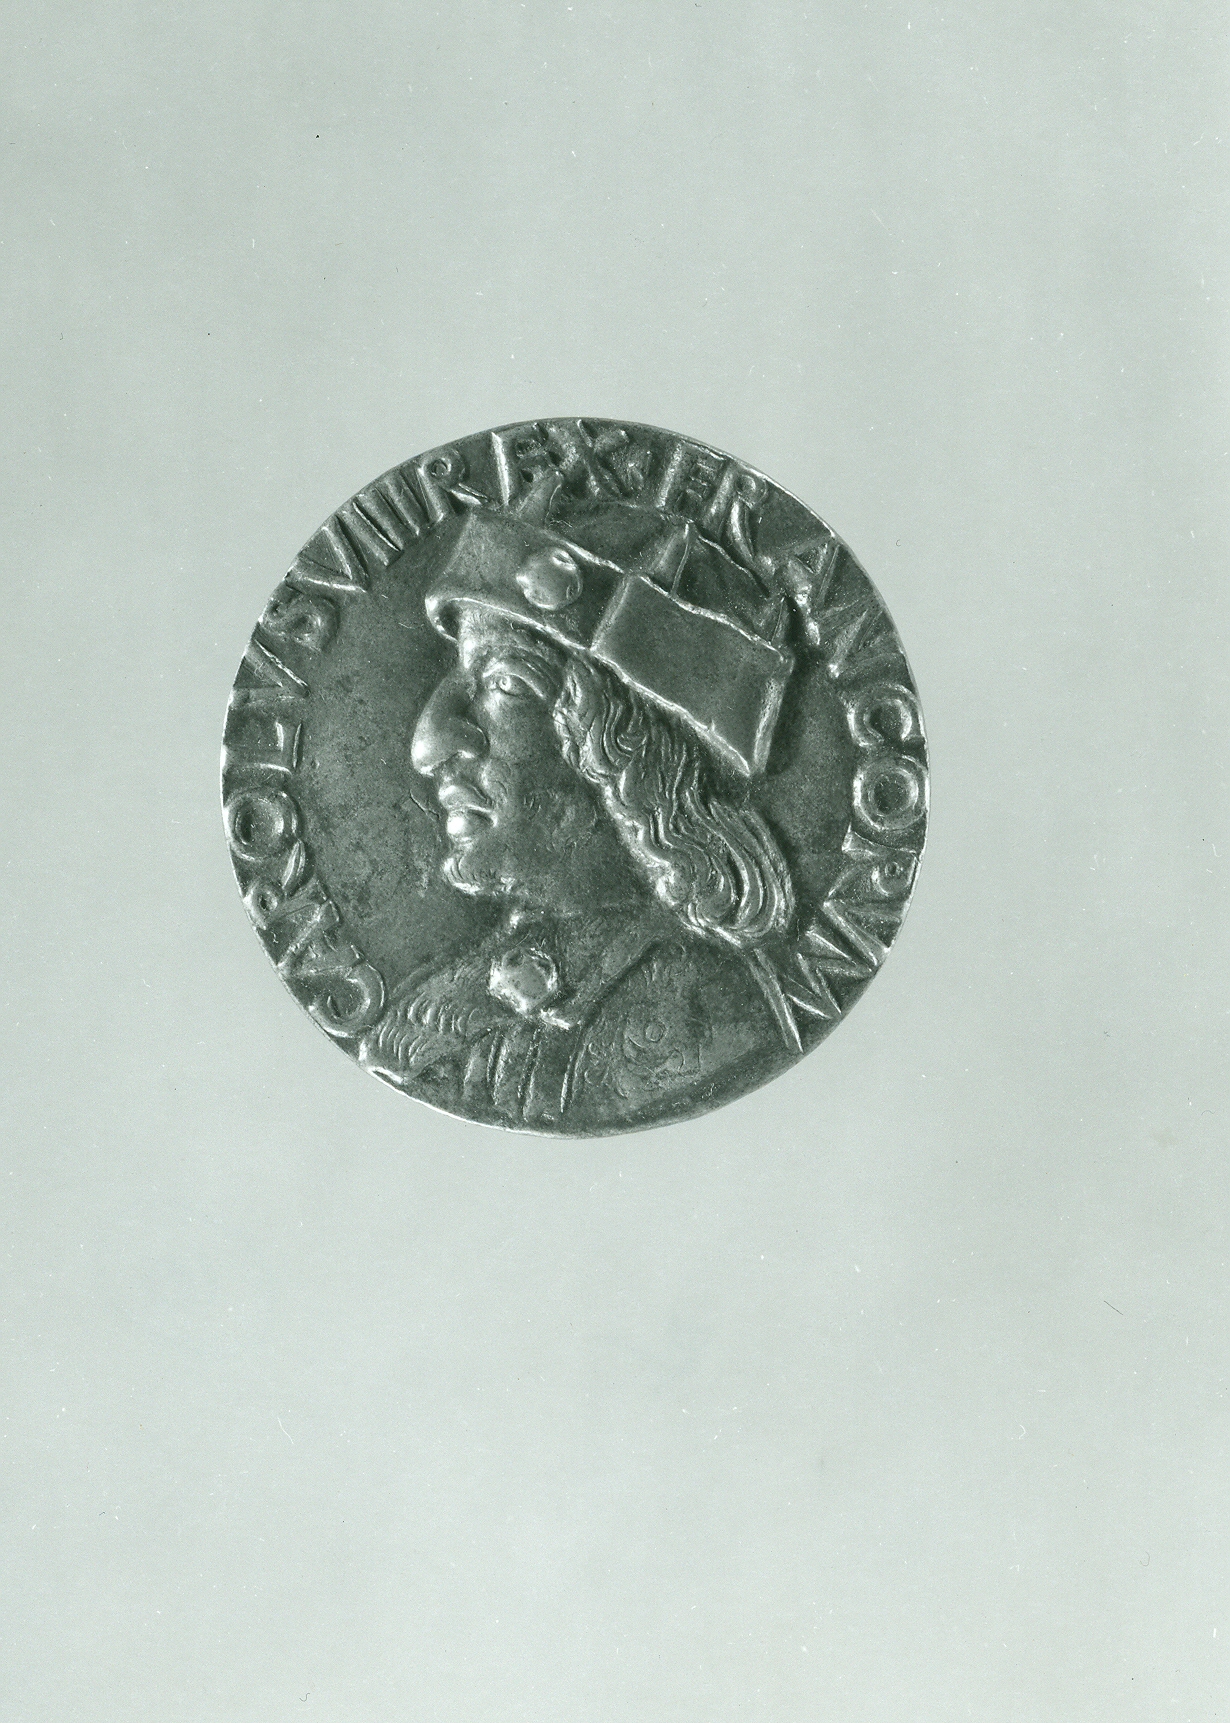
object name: medal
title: Medal: Charles VIII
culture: french or italian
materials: bronze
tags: kings,profiles,hercules,lions